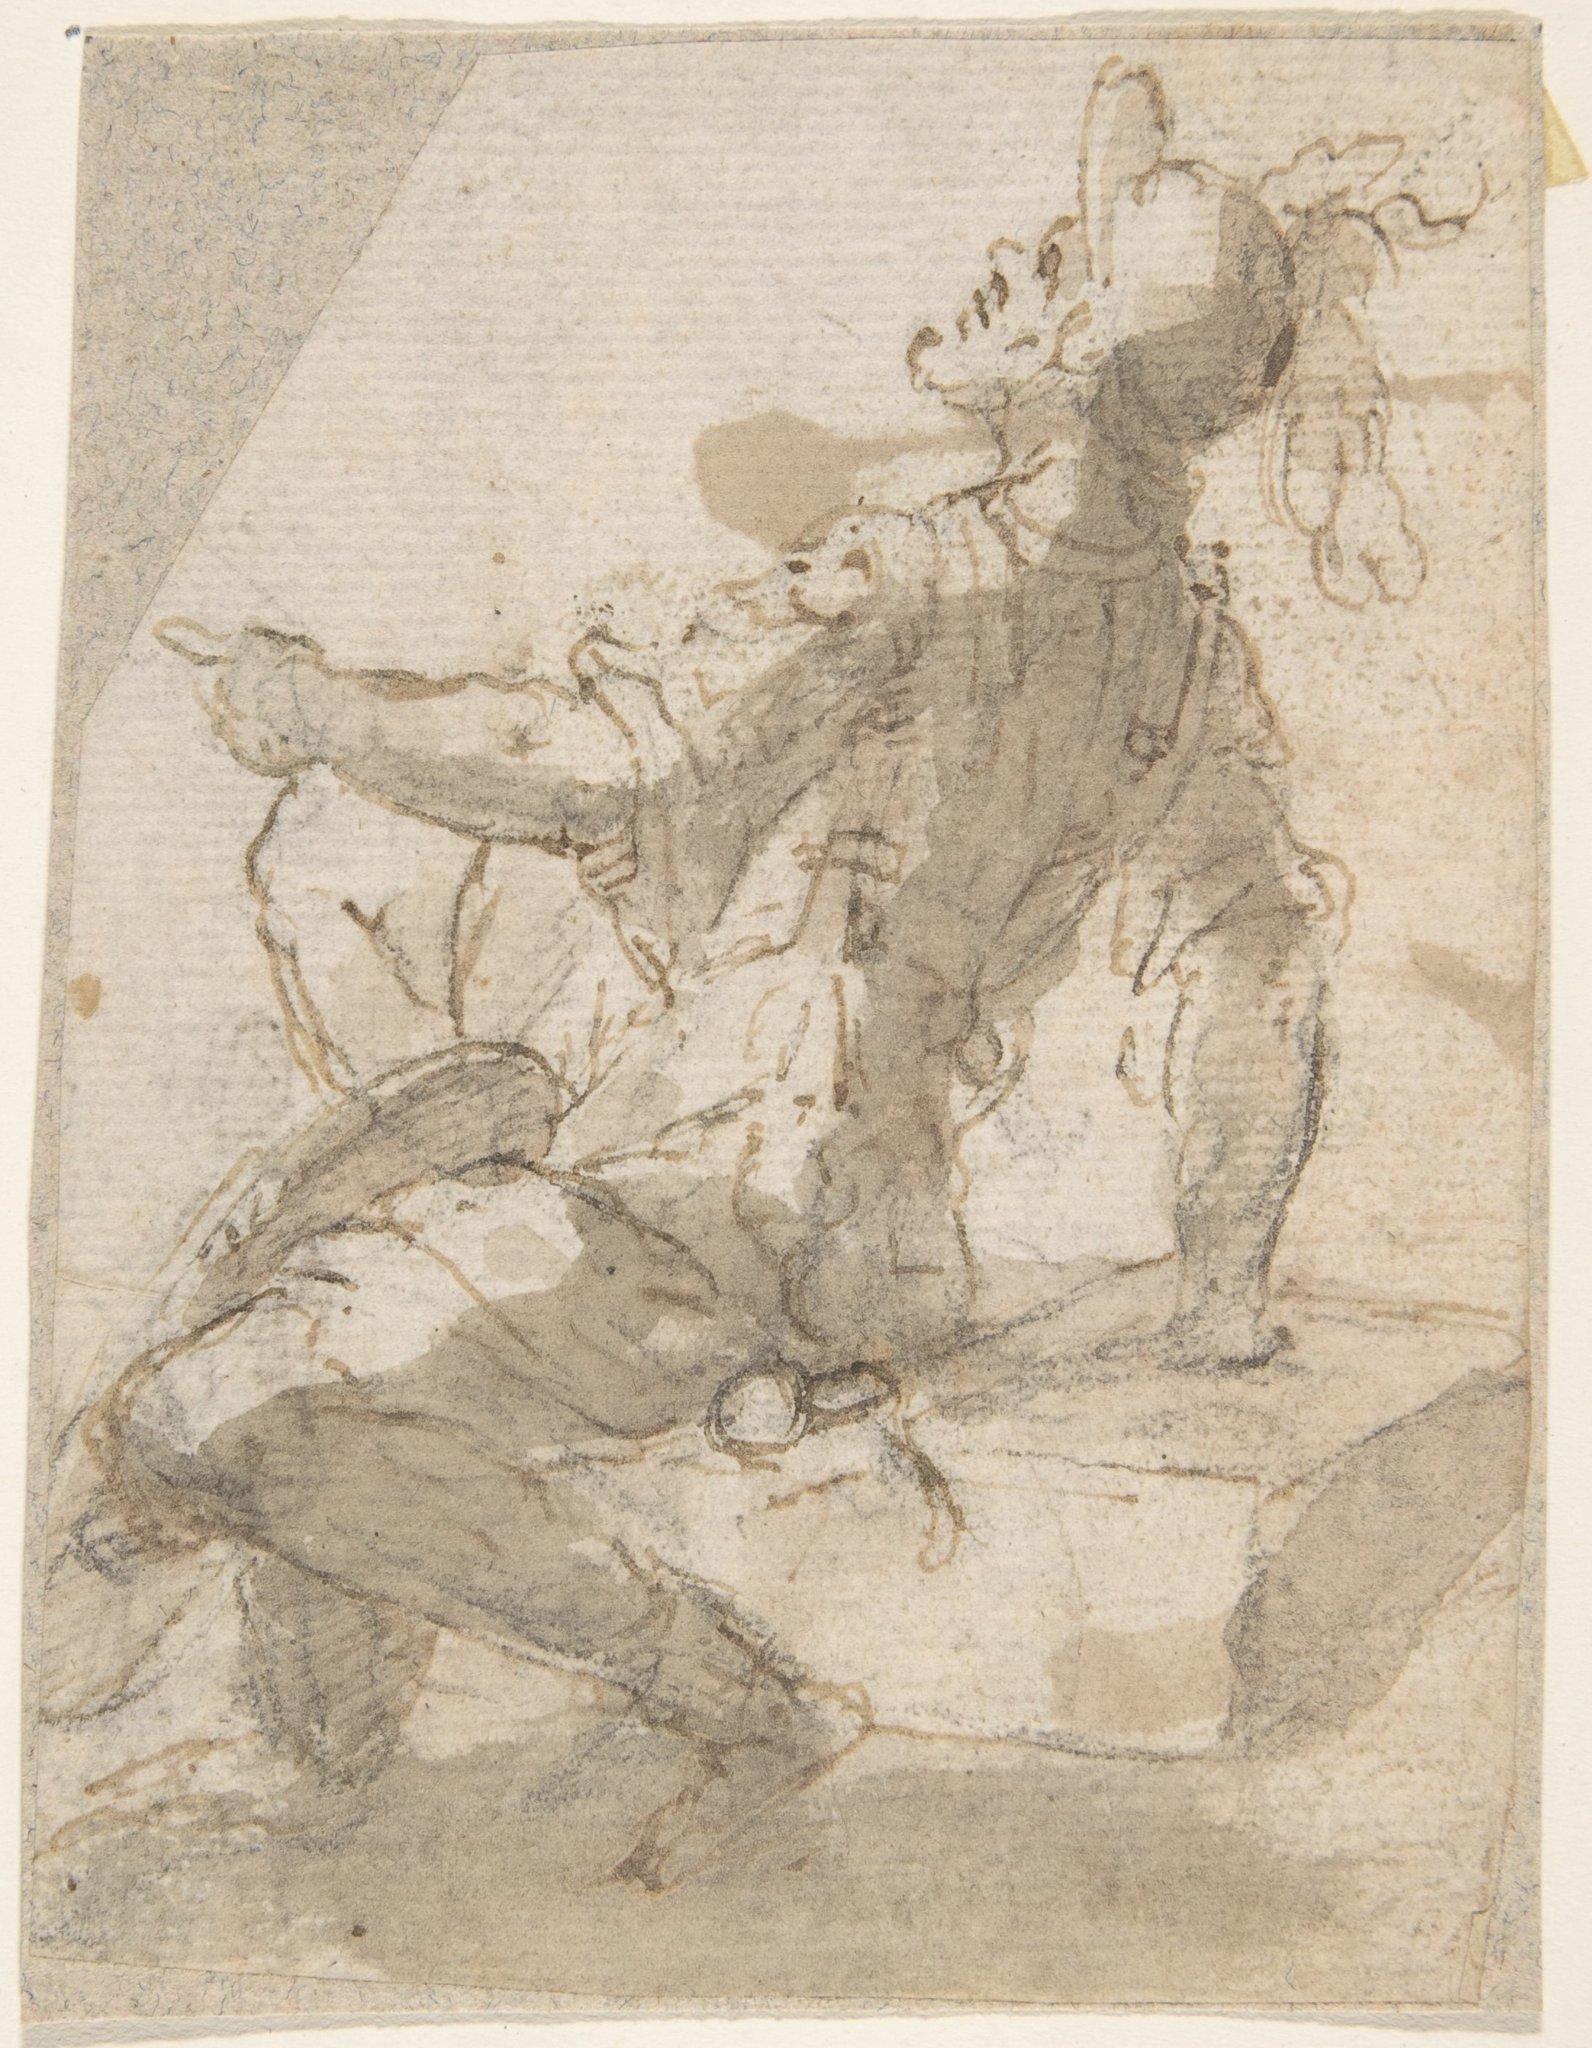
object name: drawing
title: Startled Figure of a Soldier Seated on a Block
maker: anonymous, spanish, school of seville, 17th century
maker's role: artist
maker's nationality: spanish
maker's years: 1600-1700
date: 1601-1700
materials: chalk, ink, paper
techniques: brush, pen, drawing, wash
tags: soldiers